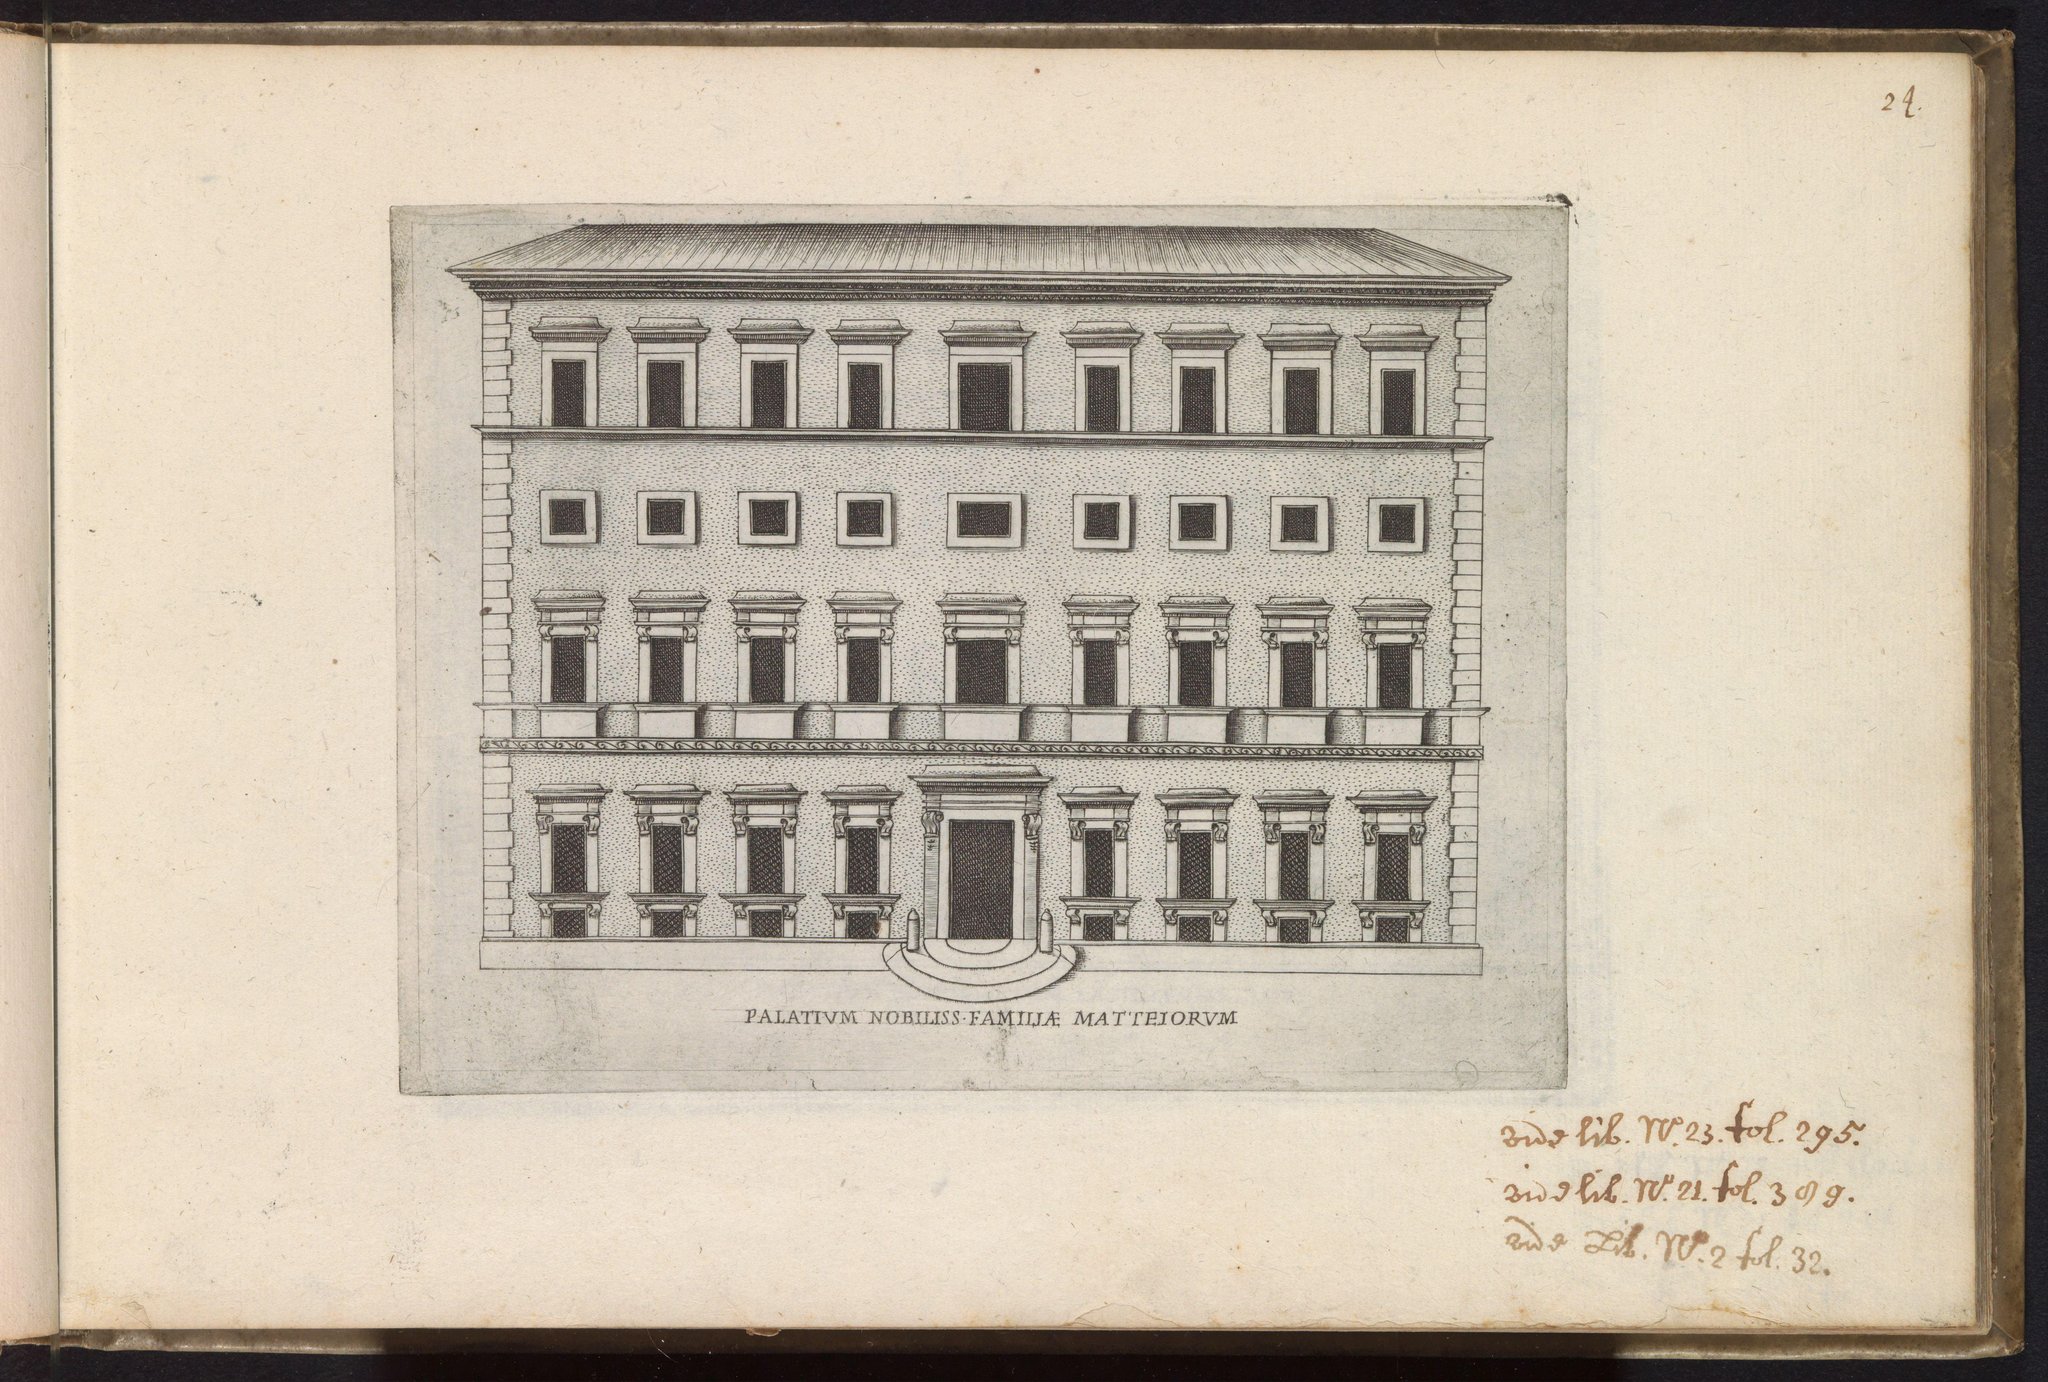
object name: print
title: Beroemde gebouwen in Rome en daarbuiten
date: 1638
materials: paper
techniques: etching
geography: rome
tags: hôtel, i.e. small palace in city, façade (of house or building)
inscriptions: number: ‘24’, inscription: ‘Ende lib. No. 23. fol. 295./ Ende lib. No. 21. fol. 389./ Ende lib. No. 2. fol. 32.’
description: Prent maakt deel uit van een reeks prenten (+ titelprent) van beroemde gebouwen in Rome en elders.